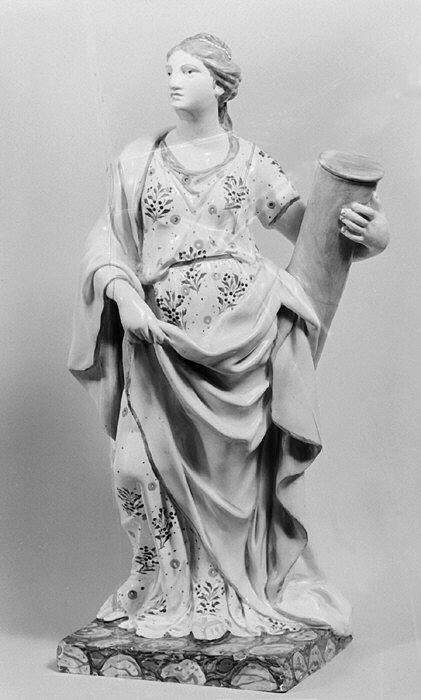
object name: figure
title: Fortitude, from a set of the Virtues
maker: wood & caldwell (enoch wood and james caldwell)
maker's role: maker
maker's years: 1790-1818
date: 1800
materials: earthenware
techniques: glazing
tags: women